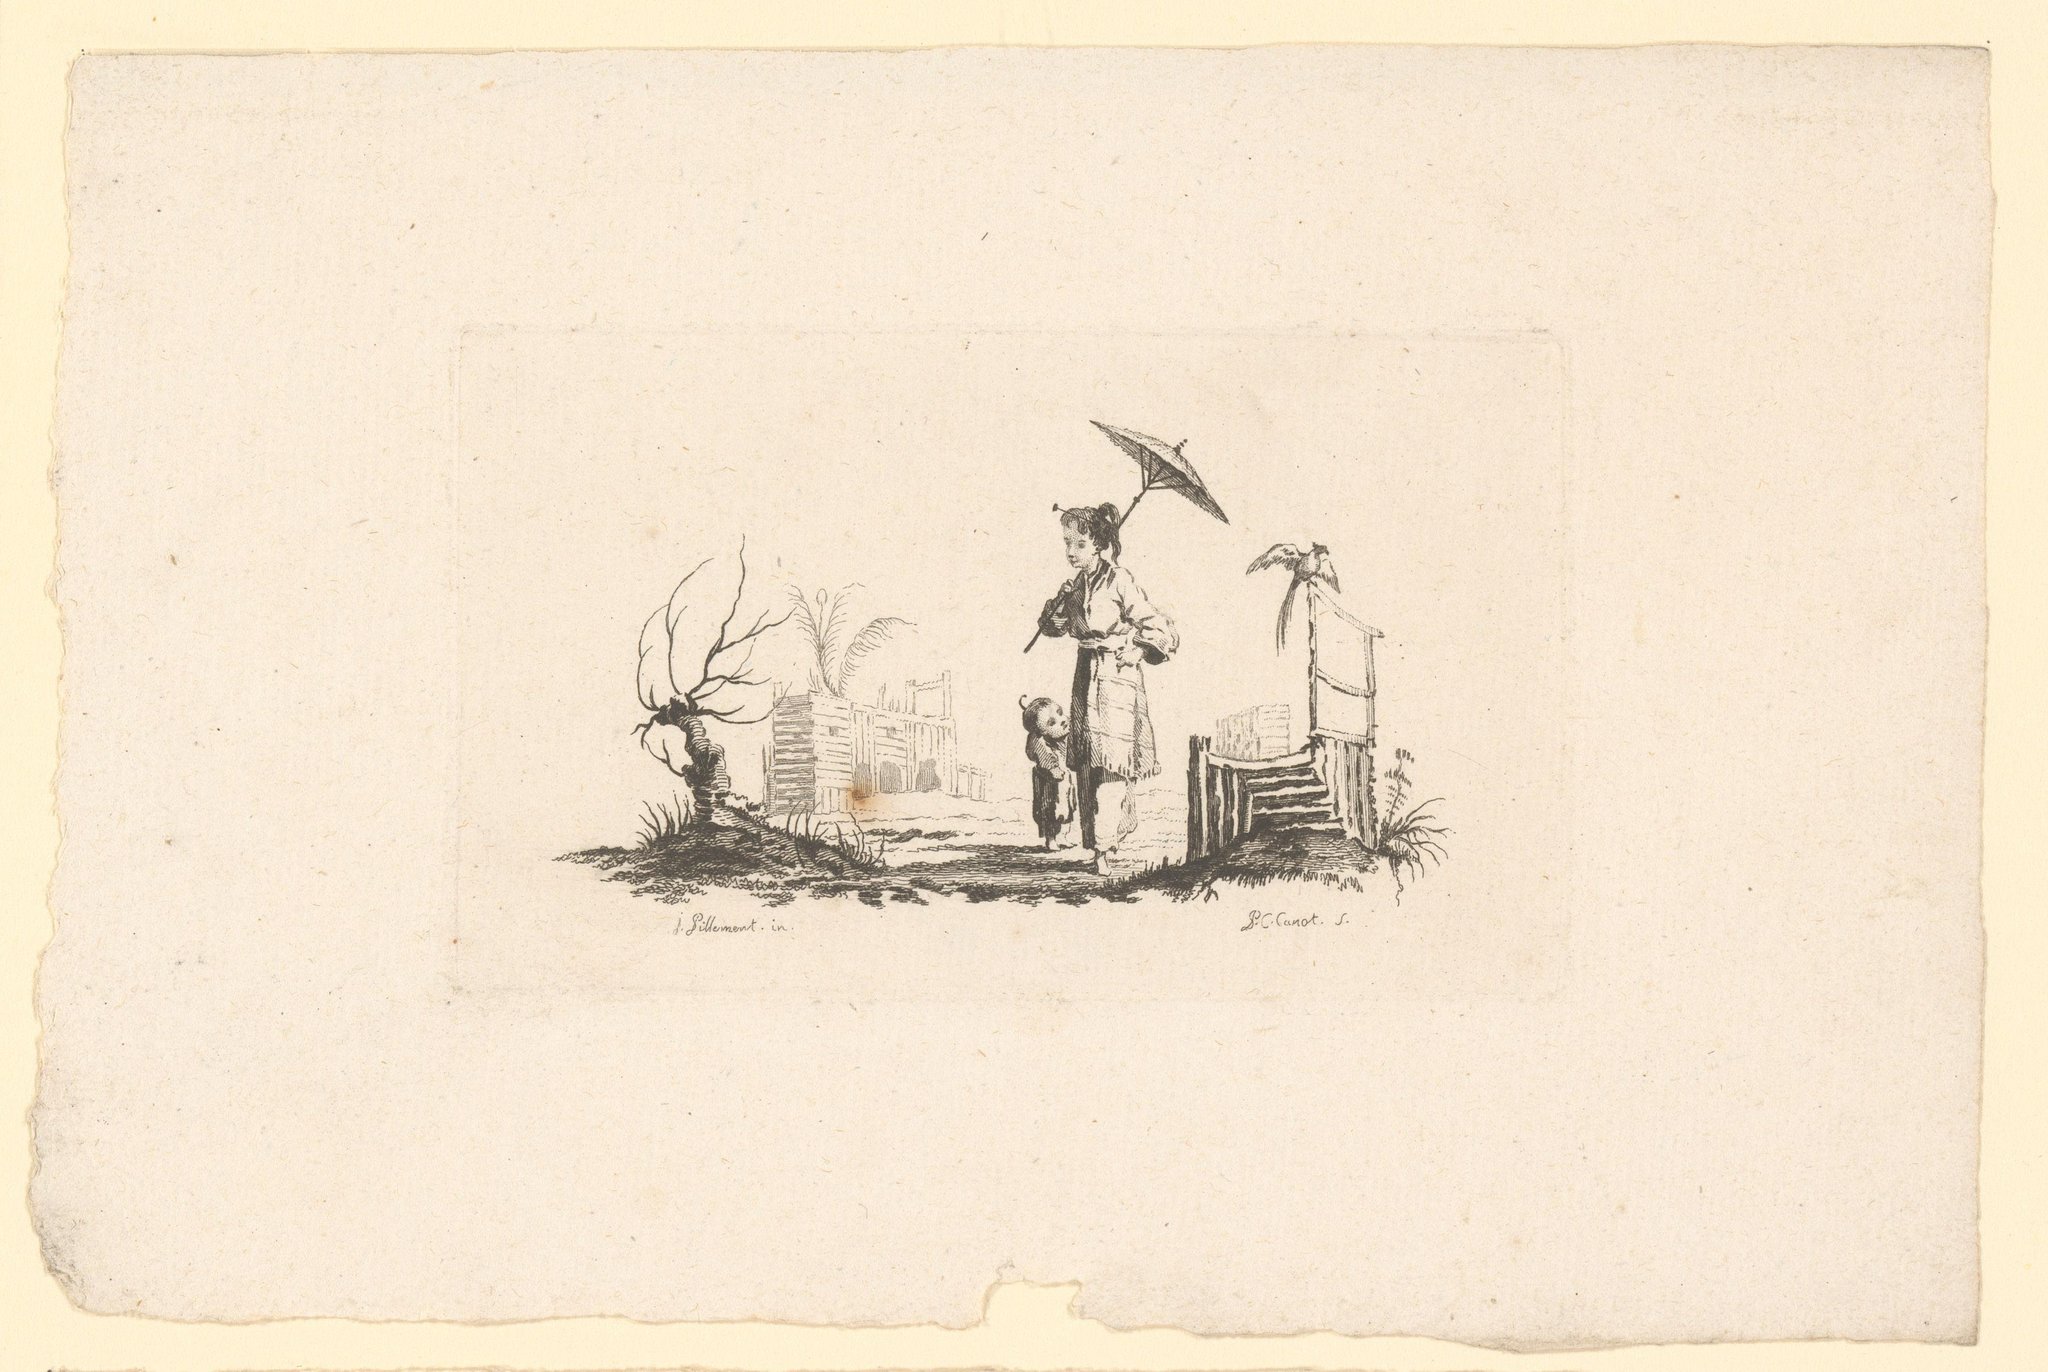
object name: print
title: Vrouw met kind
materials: paper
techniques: etching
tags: landscapes (+ landscape with figures, staffage), mother and child(ren), woman and child(ren) (family group)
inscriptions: collector's mark: Lugt 2228, collector's mark: Lugt 2760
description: Een vrouw met een parasol loopt in een landschap, naast haar loopt een klein kind.